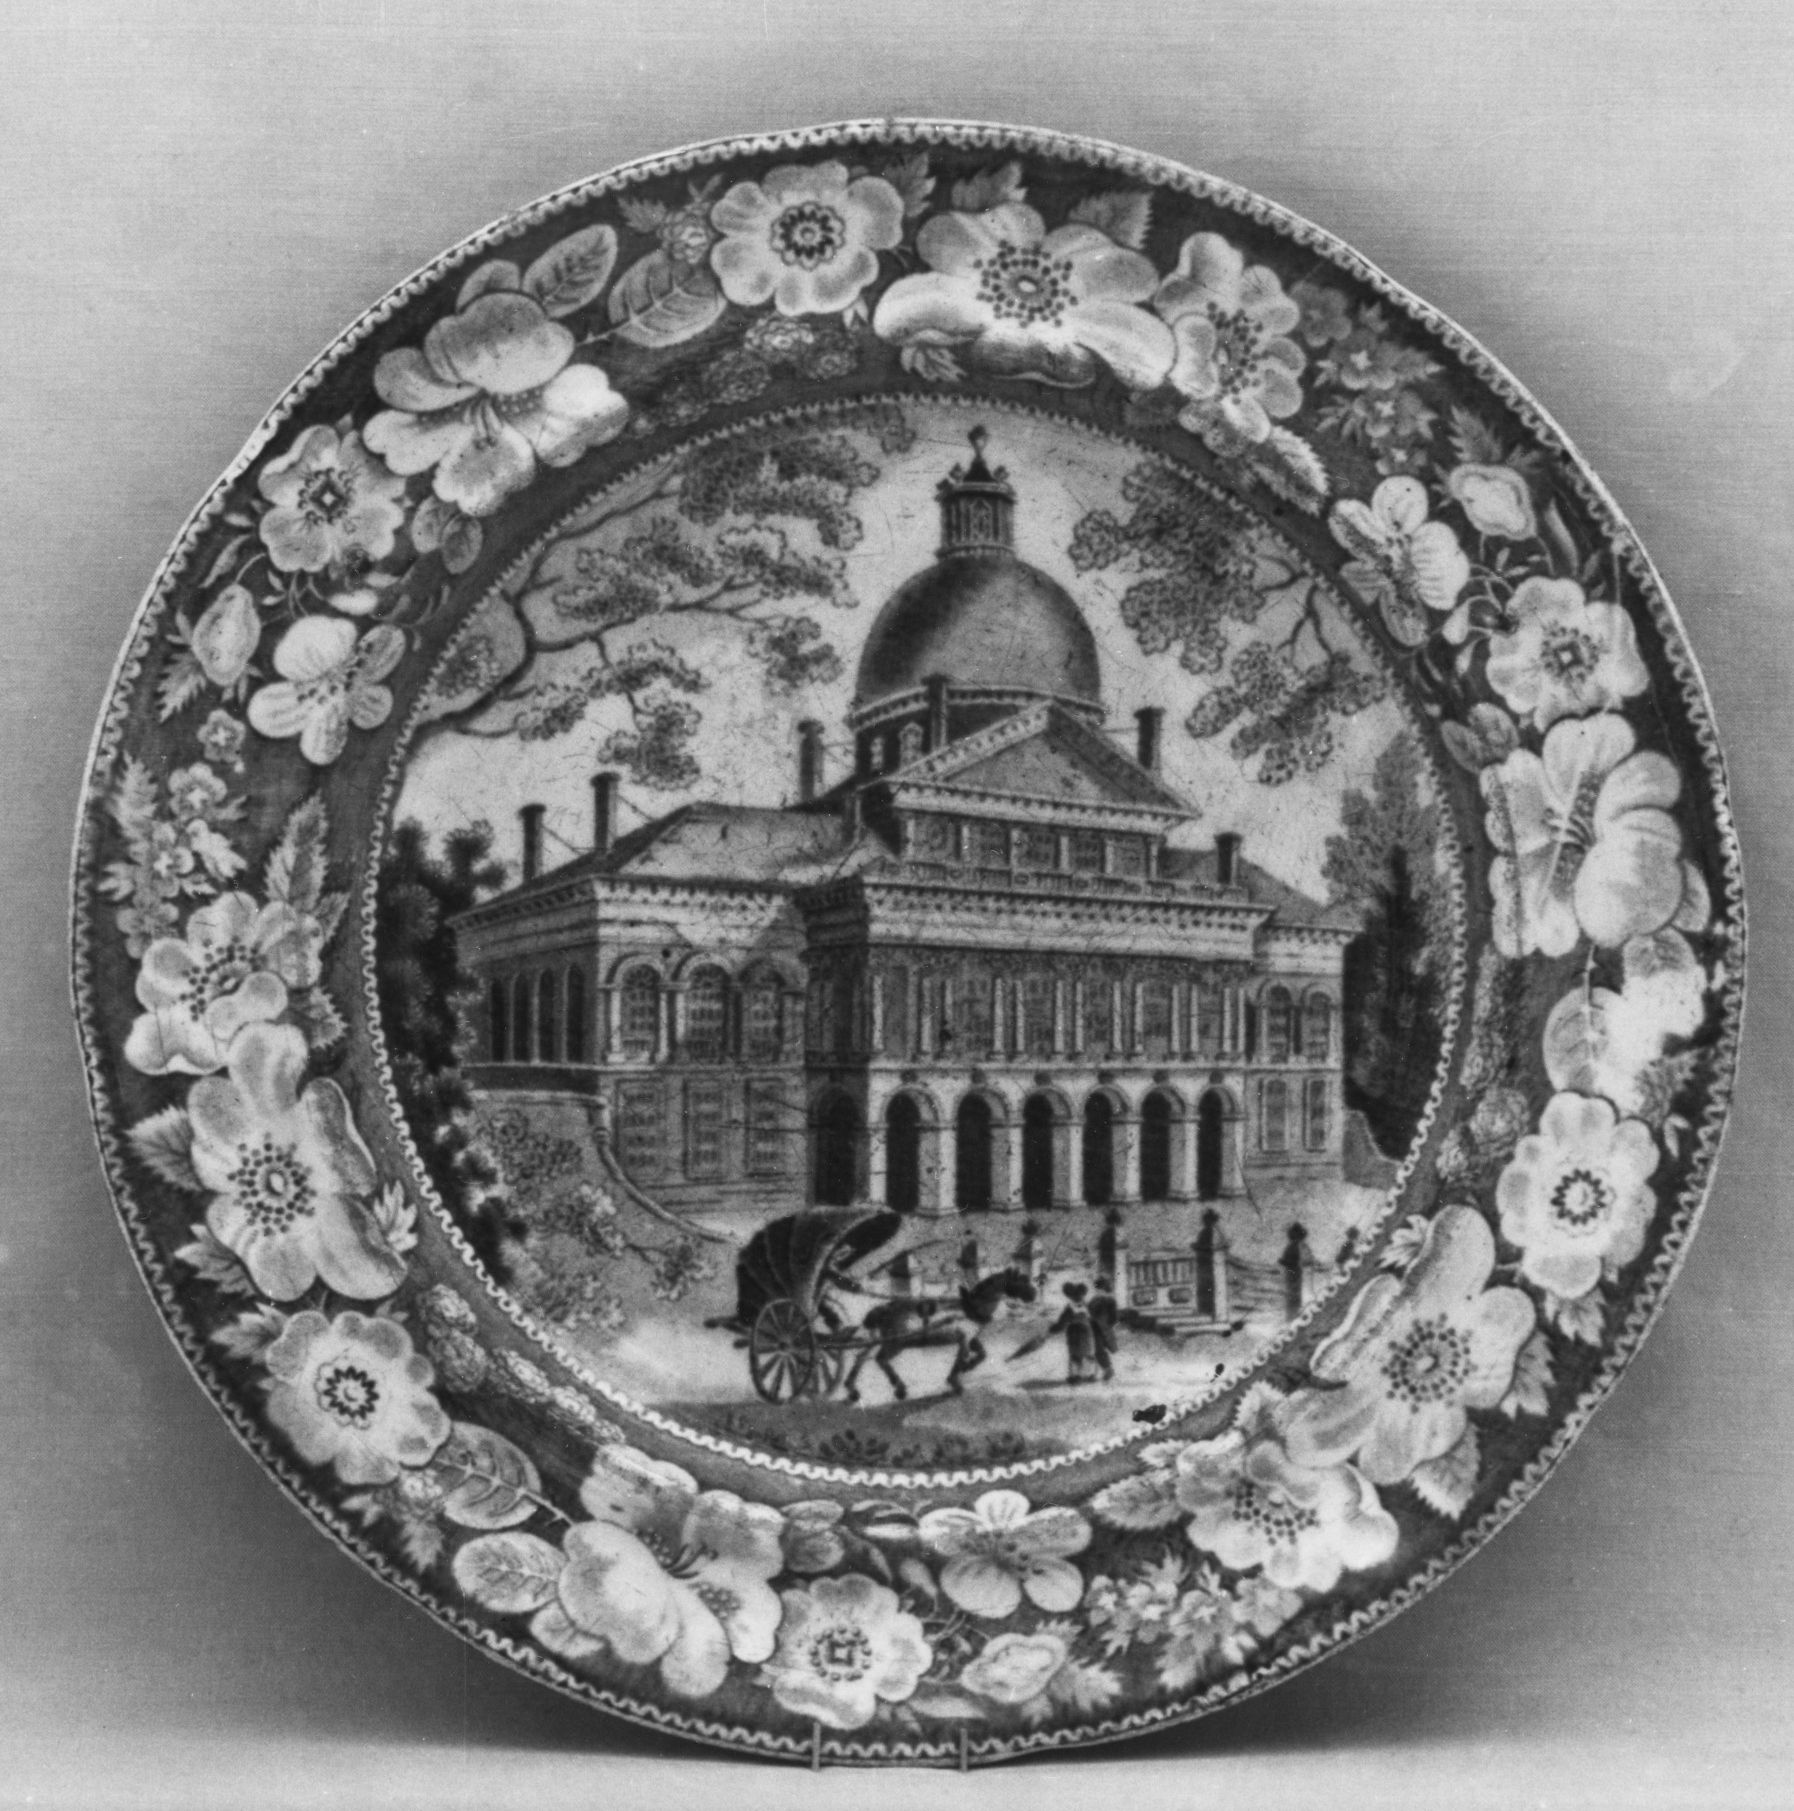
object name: plate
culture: british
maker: enoch wood & sons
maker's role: maker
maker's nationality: british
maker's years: 1818-1846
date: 1818-1846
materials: earthenware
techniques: transfer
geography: england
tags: buildings,flowers,carriages